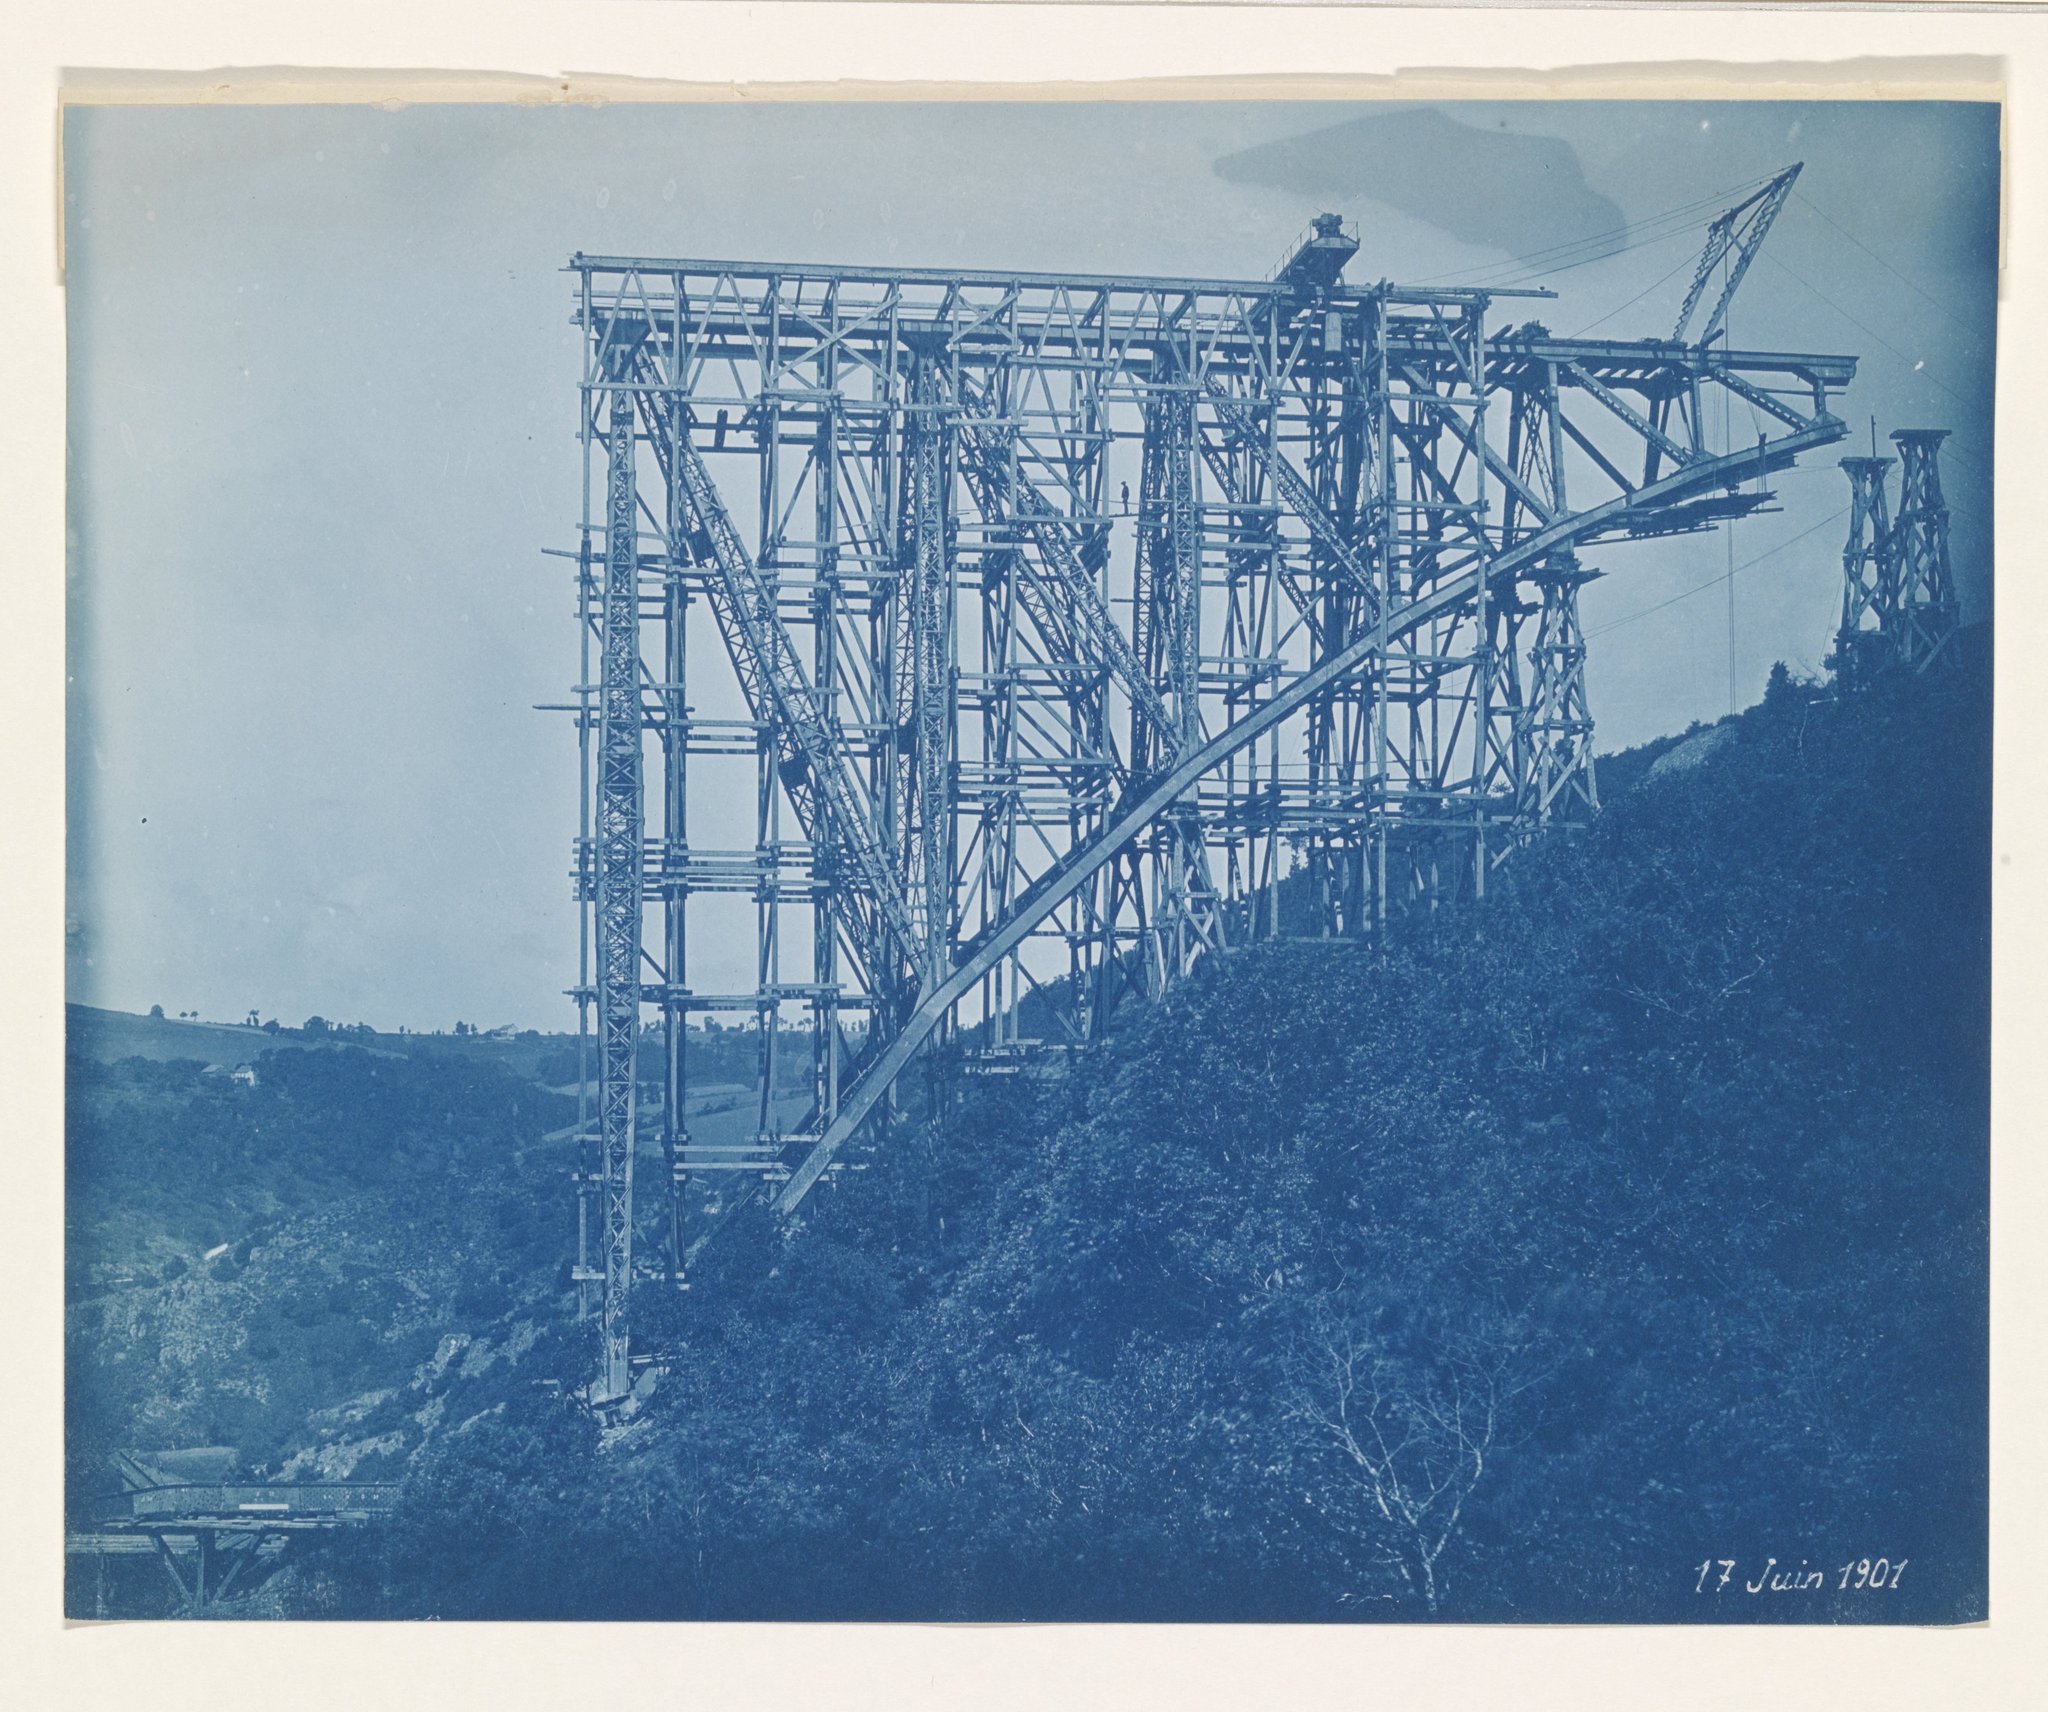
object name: photograph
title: The Construction of the Viaur Viaduct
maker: Anonymous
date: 1901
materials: photographic support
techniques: cyanotype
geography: france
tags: viaduct, making the overground structures (~ building activities)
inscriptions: date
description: The Viaur Viaduct took seven years to build, from 1895 to 1902. Its progress was recorded every few months by a possibly local photographer. He must have carried out daredevil feats in the mountainous region in order to take good pictures of the bridge and its parts. In their time, these modernistic photographs were nothing more than helpful tools for the architects.